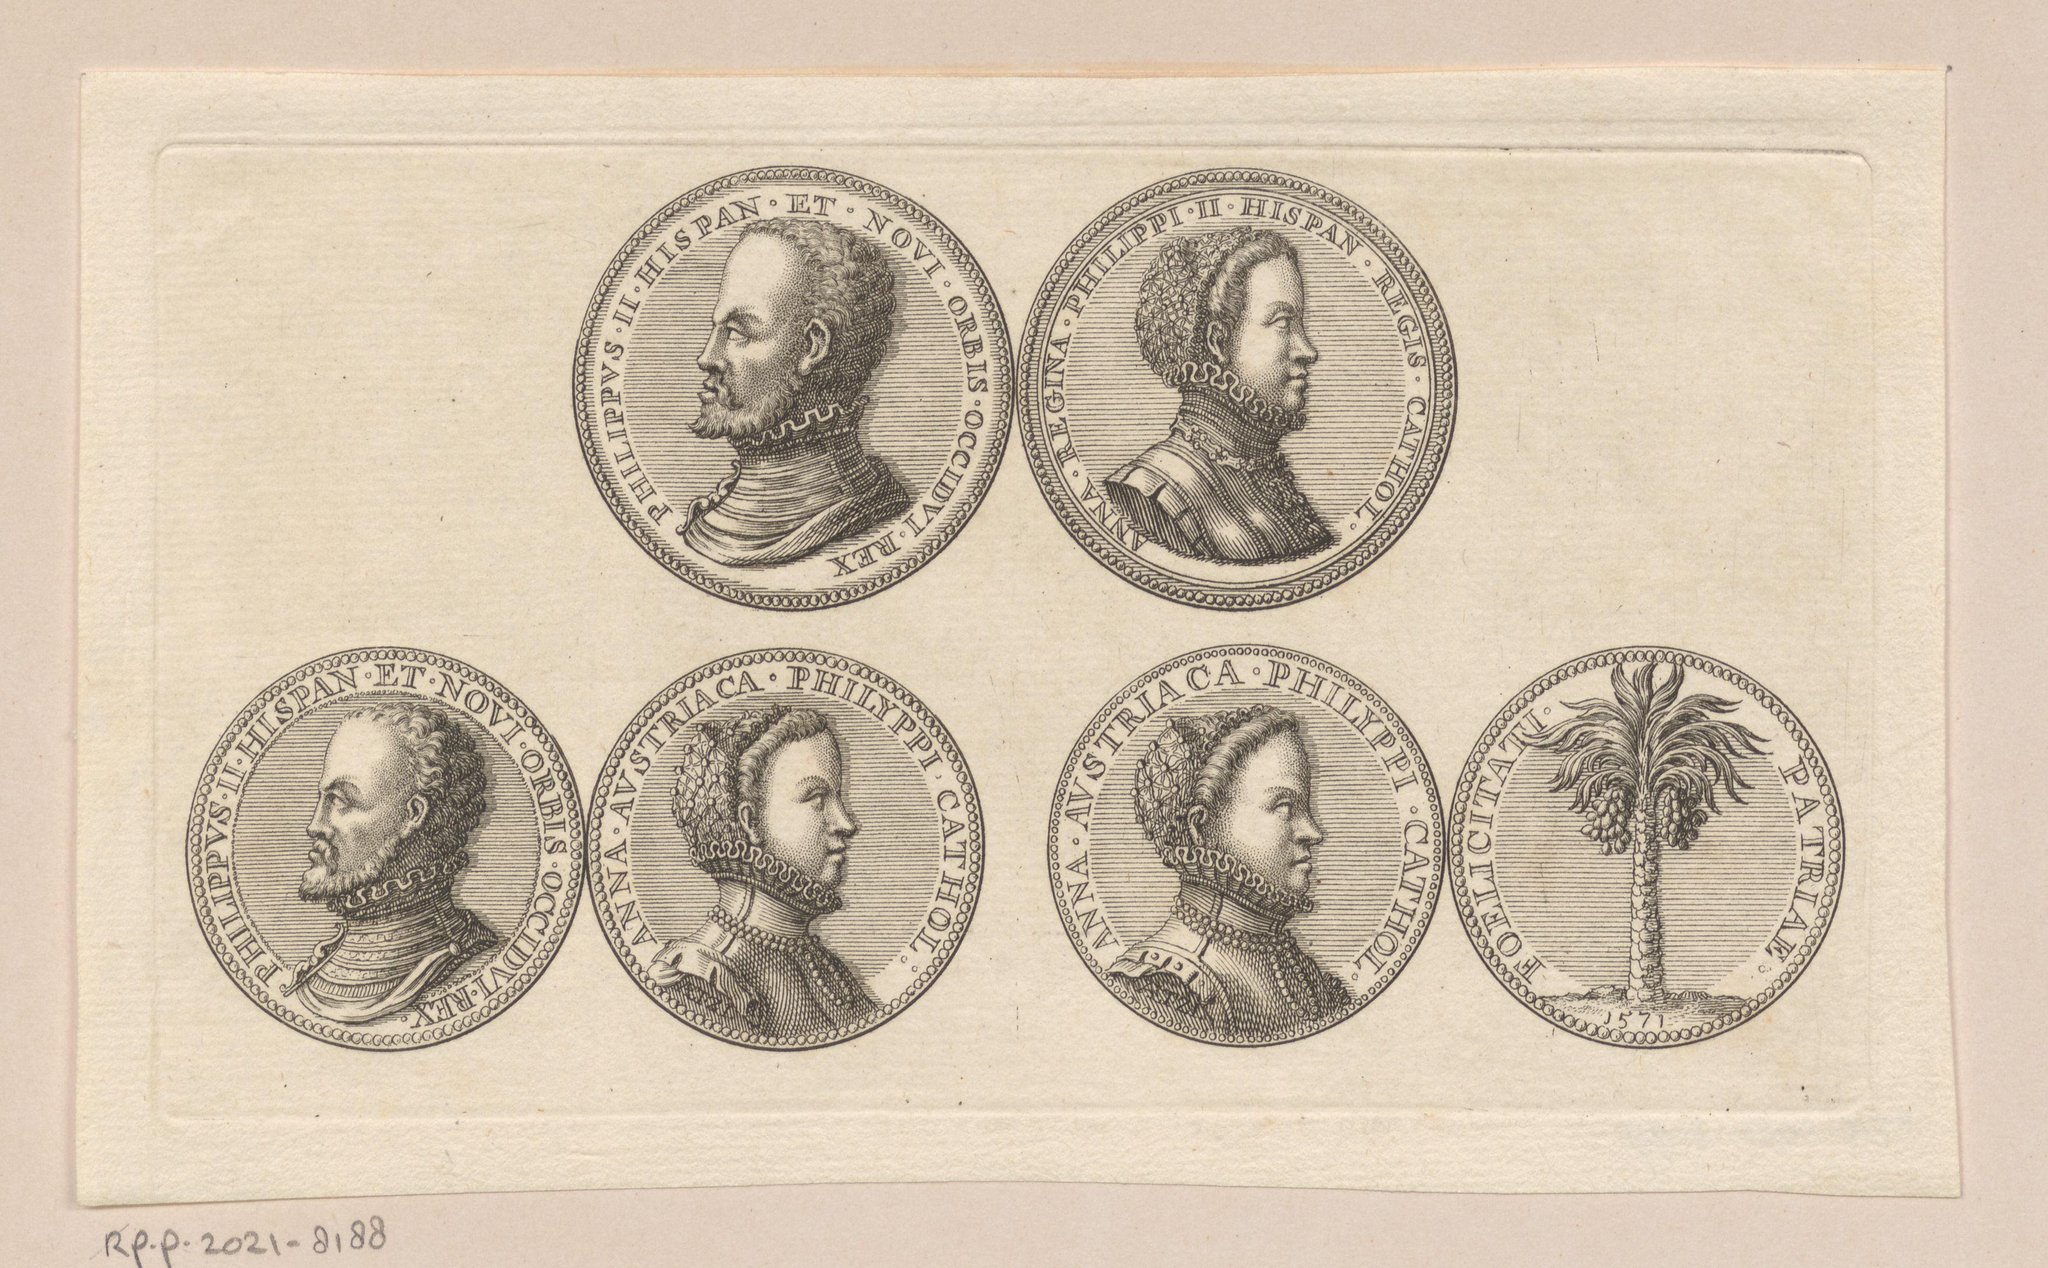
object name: print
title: Penningen met de portretten van Filips II en Anna-Maria van Oostenrijk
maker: Anonymous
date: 1723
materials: paper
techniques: engraving, etching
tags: philip ii of spain, historical persons, coin, trees: palm-tree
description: Prent met tekst op verso gebruikt in: Loon, Gerard van. Beschryving der Nederlandsche Historipenningen (...). Den Haag: Christiaan van Lom, Isaac Vaillant, Pieter Gosse, Rutger Alberts en Pieter de Hondt, 1723, dl. 1.